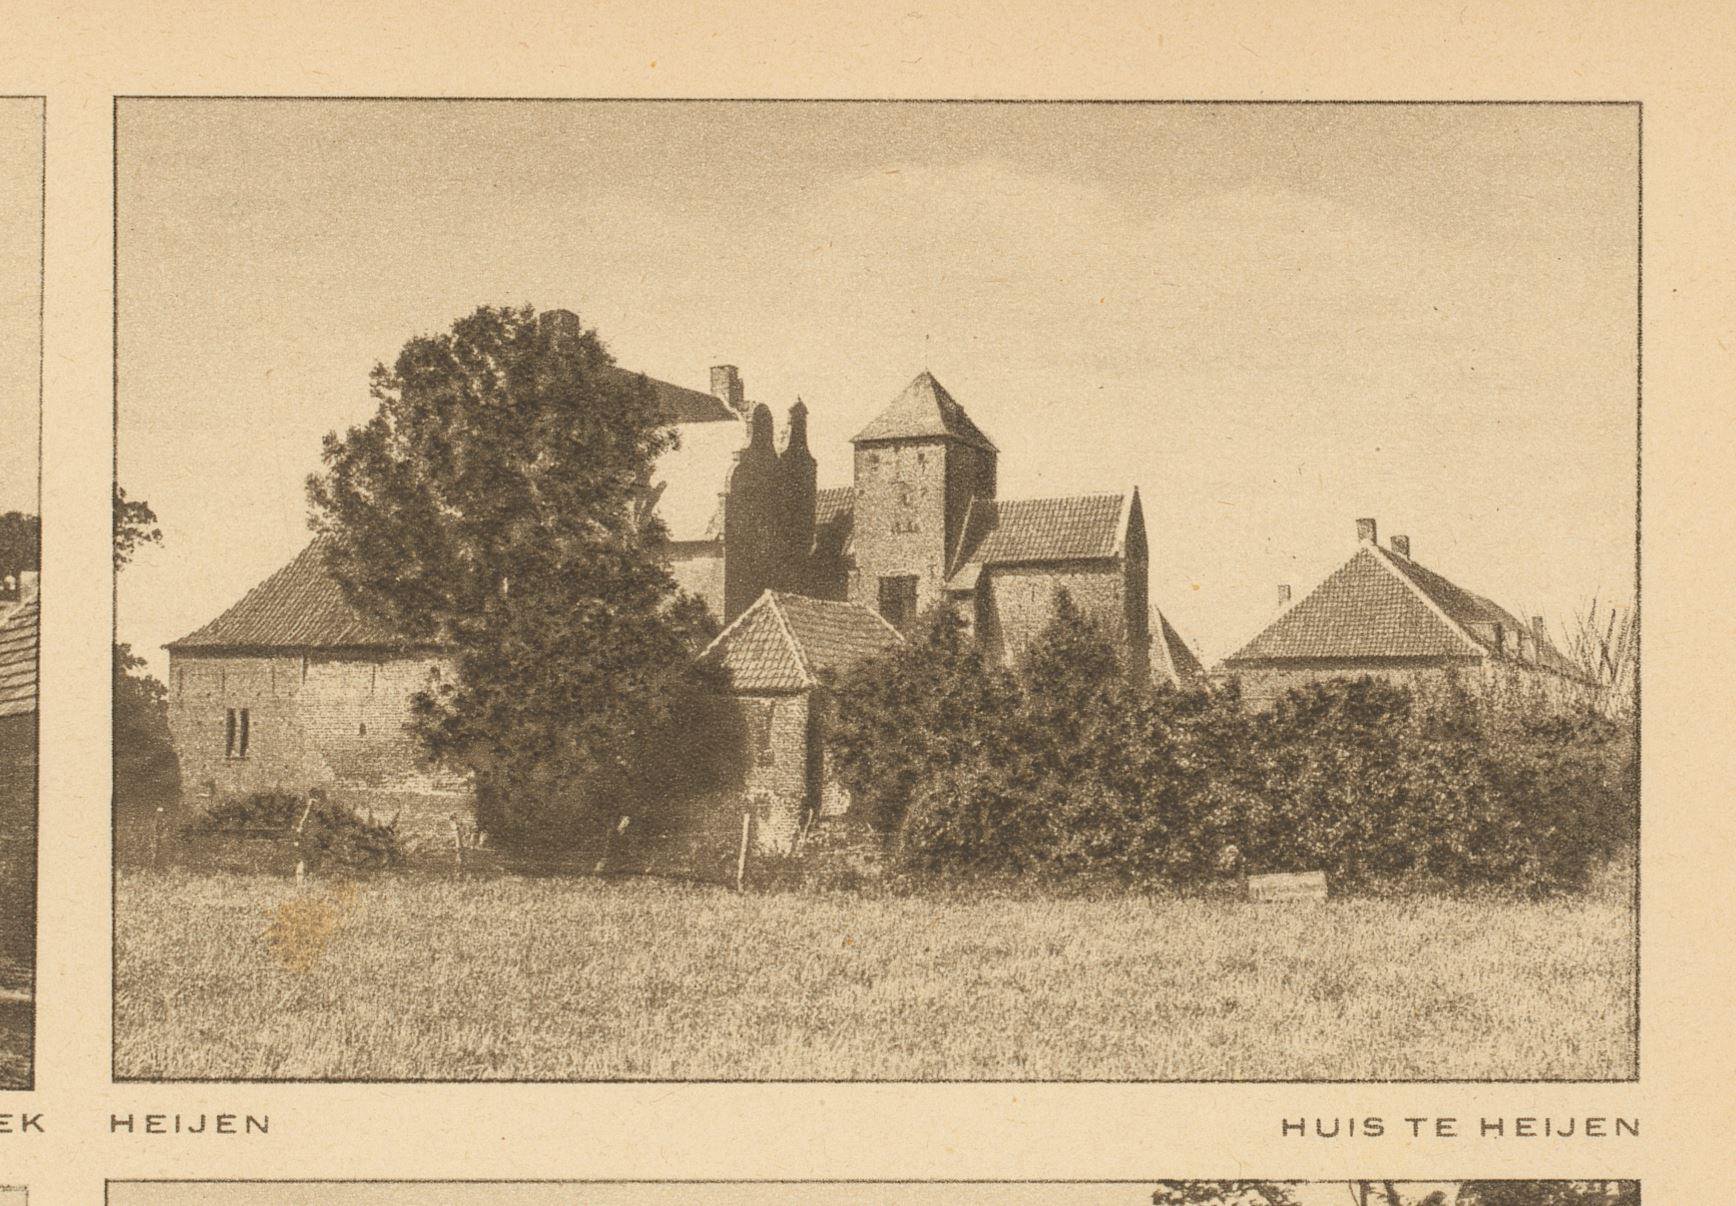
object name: photomechanical print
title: Gezicht op Huis Heijen in Heijen, Limburg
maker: Anonymous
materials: paper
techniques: rotogravure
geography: leiden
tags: castle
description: Deze prent maakt deel uit van een album.